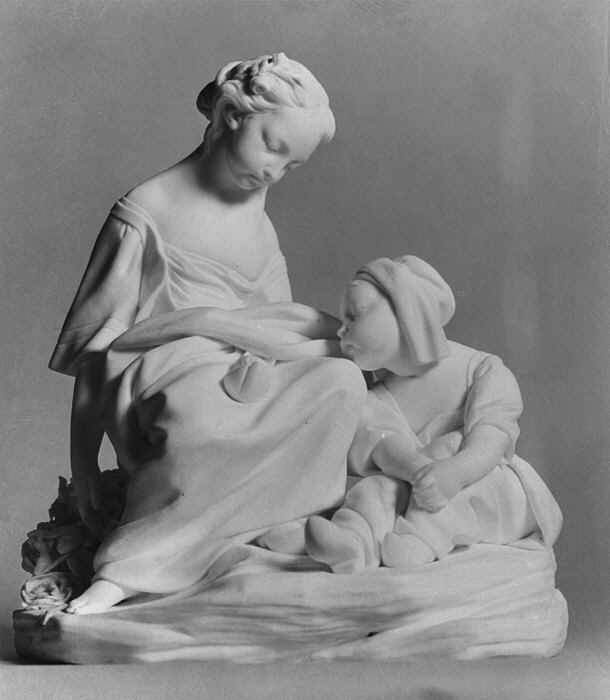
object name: group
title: The Broken Shoe (Le Sabot Cassé)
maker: sèvres manufactory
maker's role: manufactory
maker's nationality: french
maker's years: 1740-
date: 1760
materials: biscuit, paste, porcelain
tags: children,women